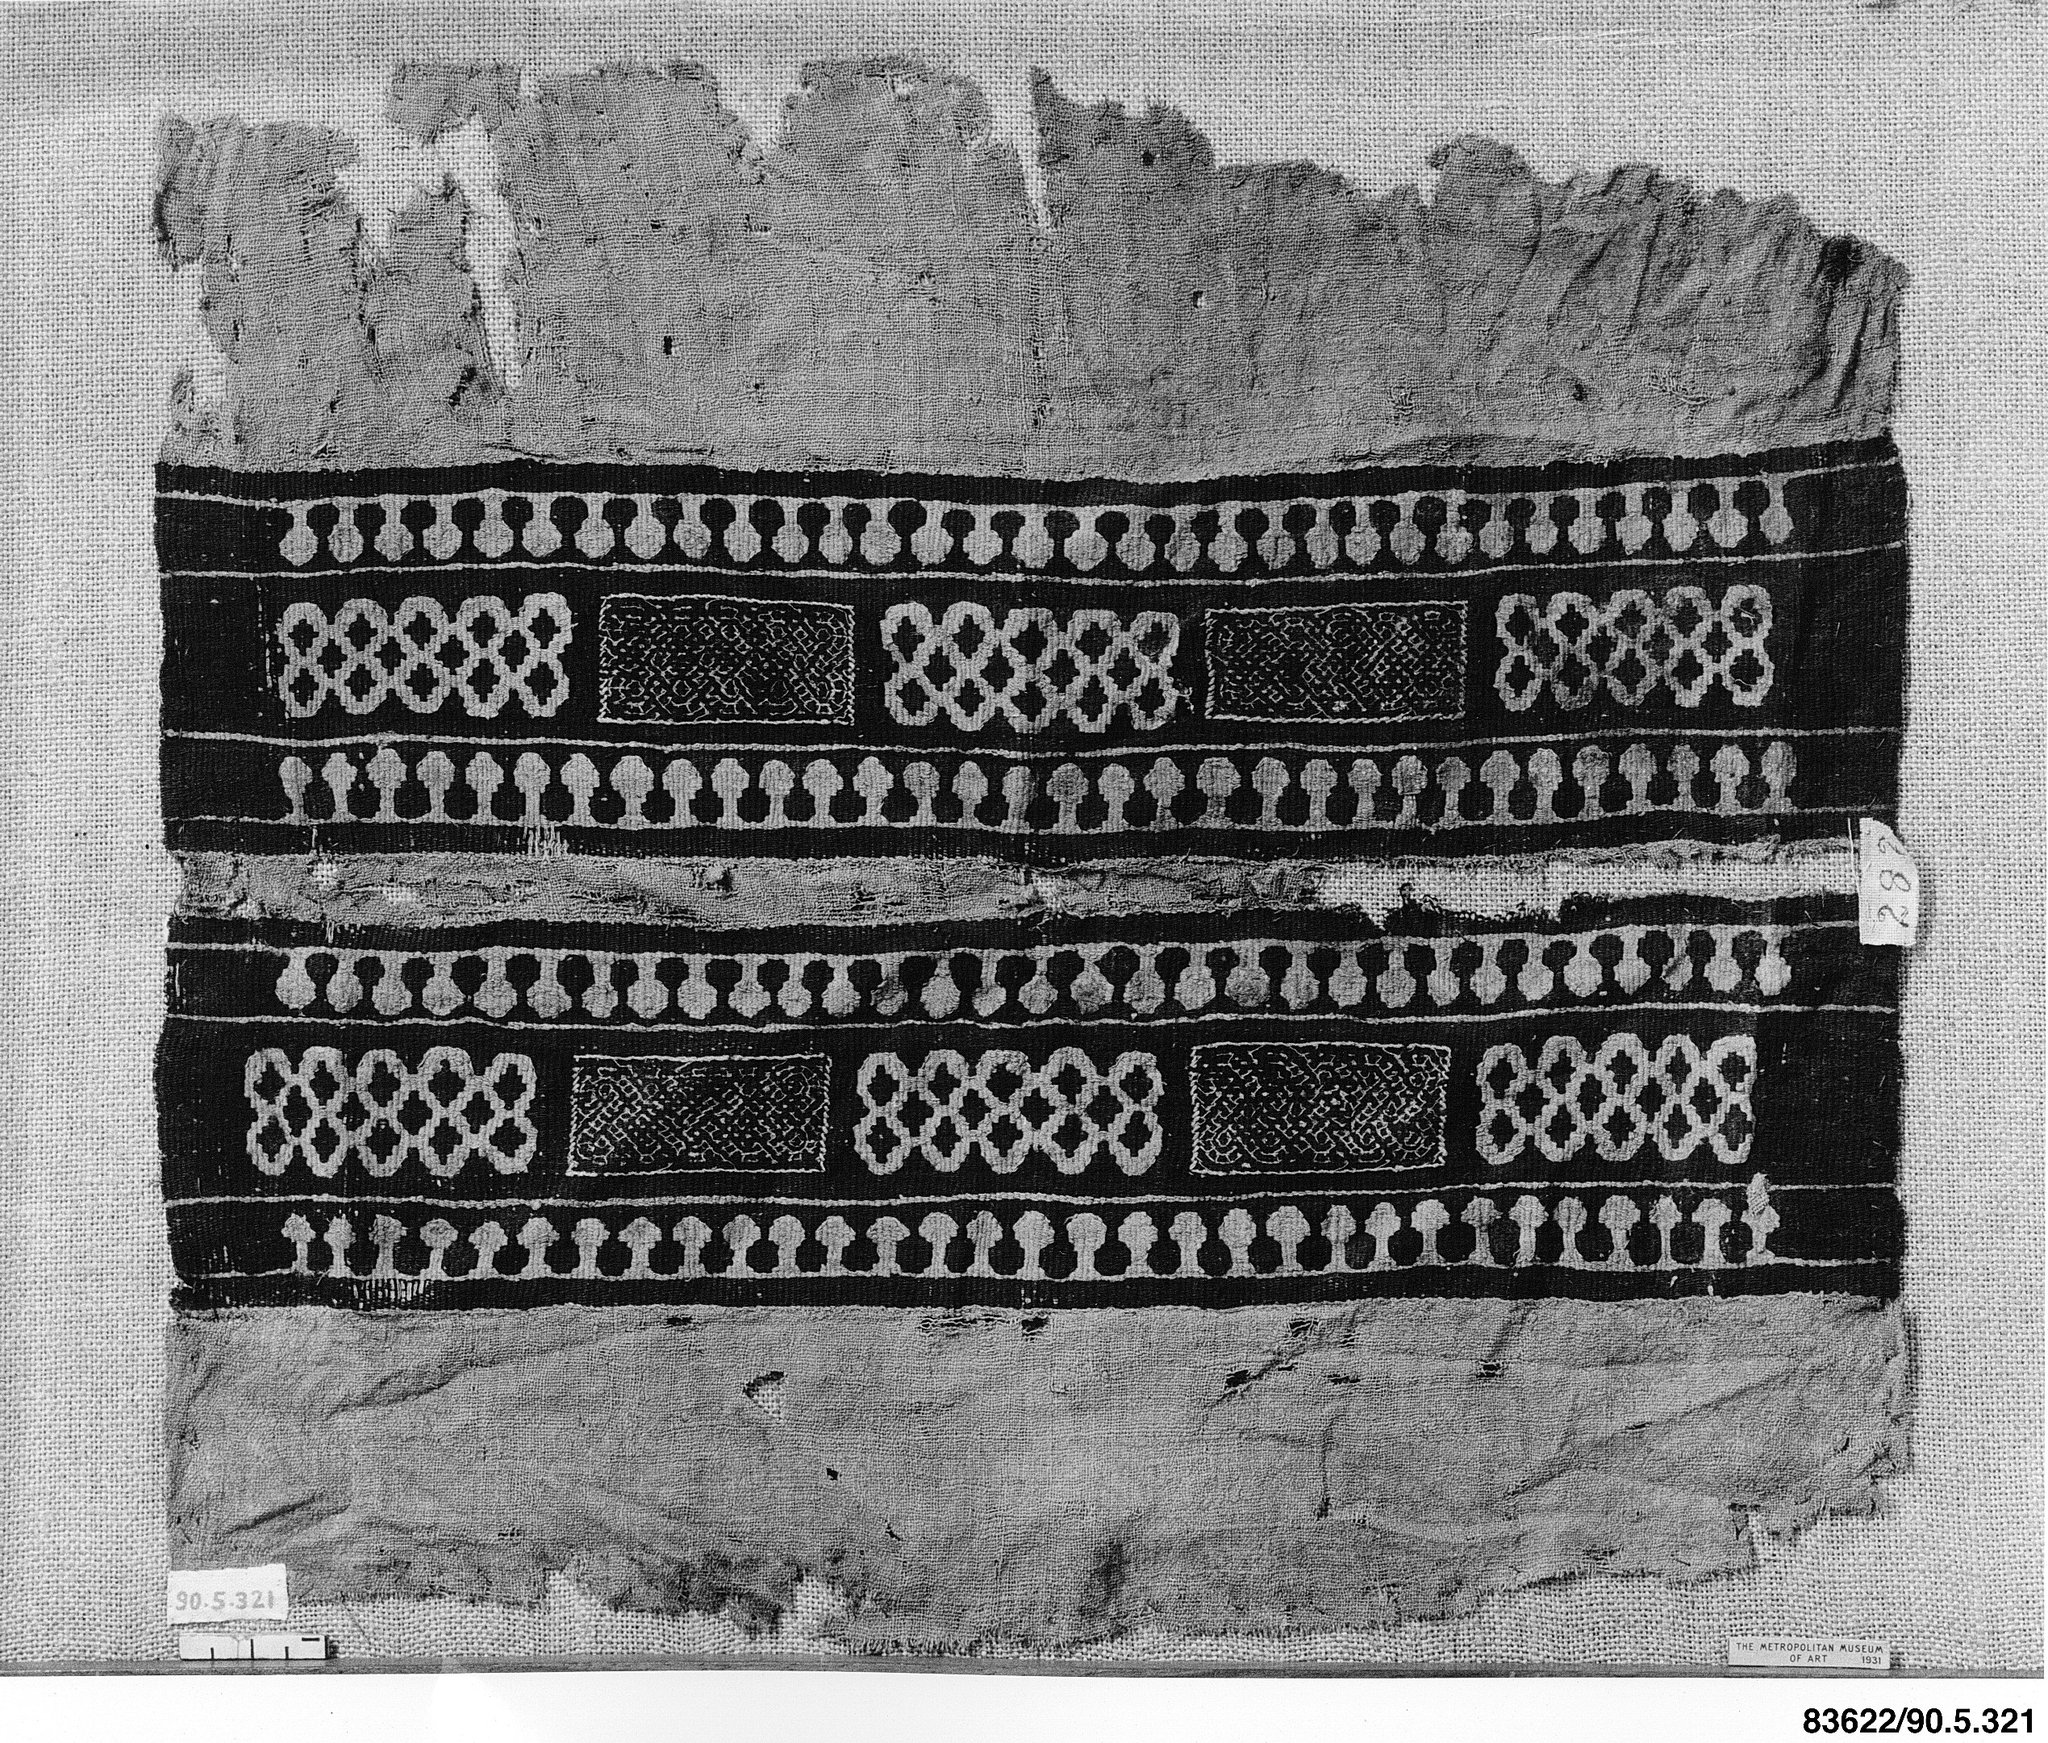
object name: textile fragment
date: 201-400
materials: linen, wool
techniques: weave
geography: egypt